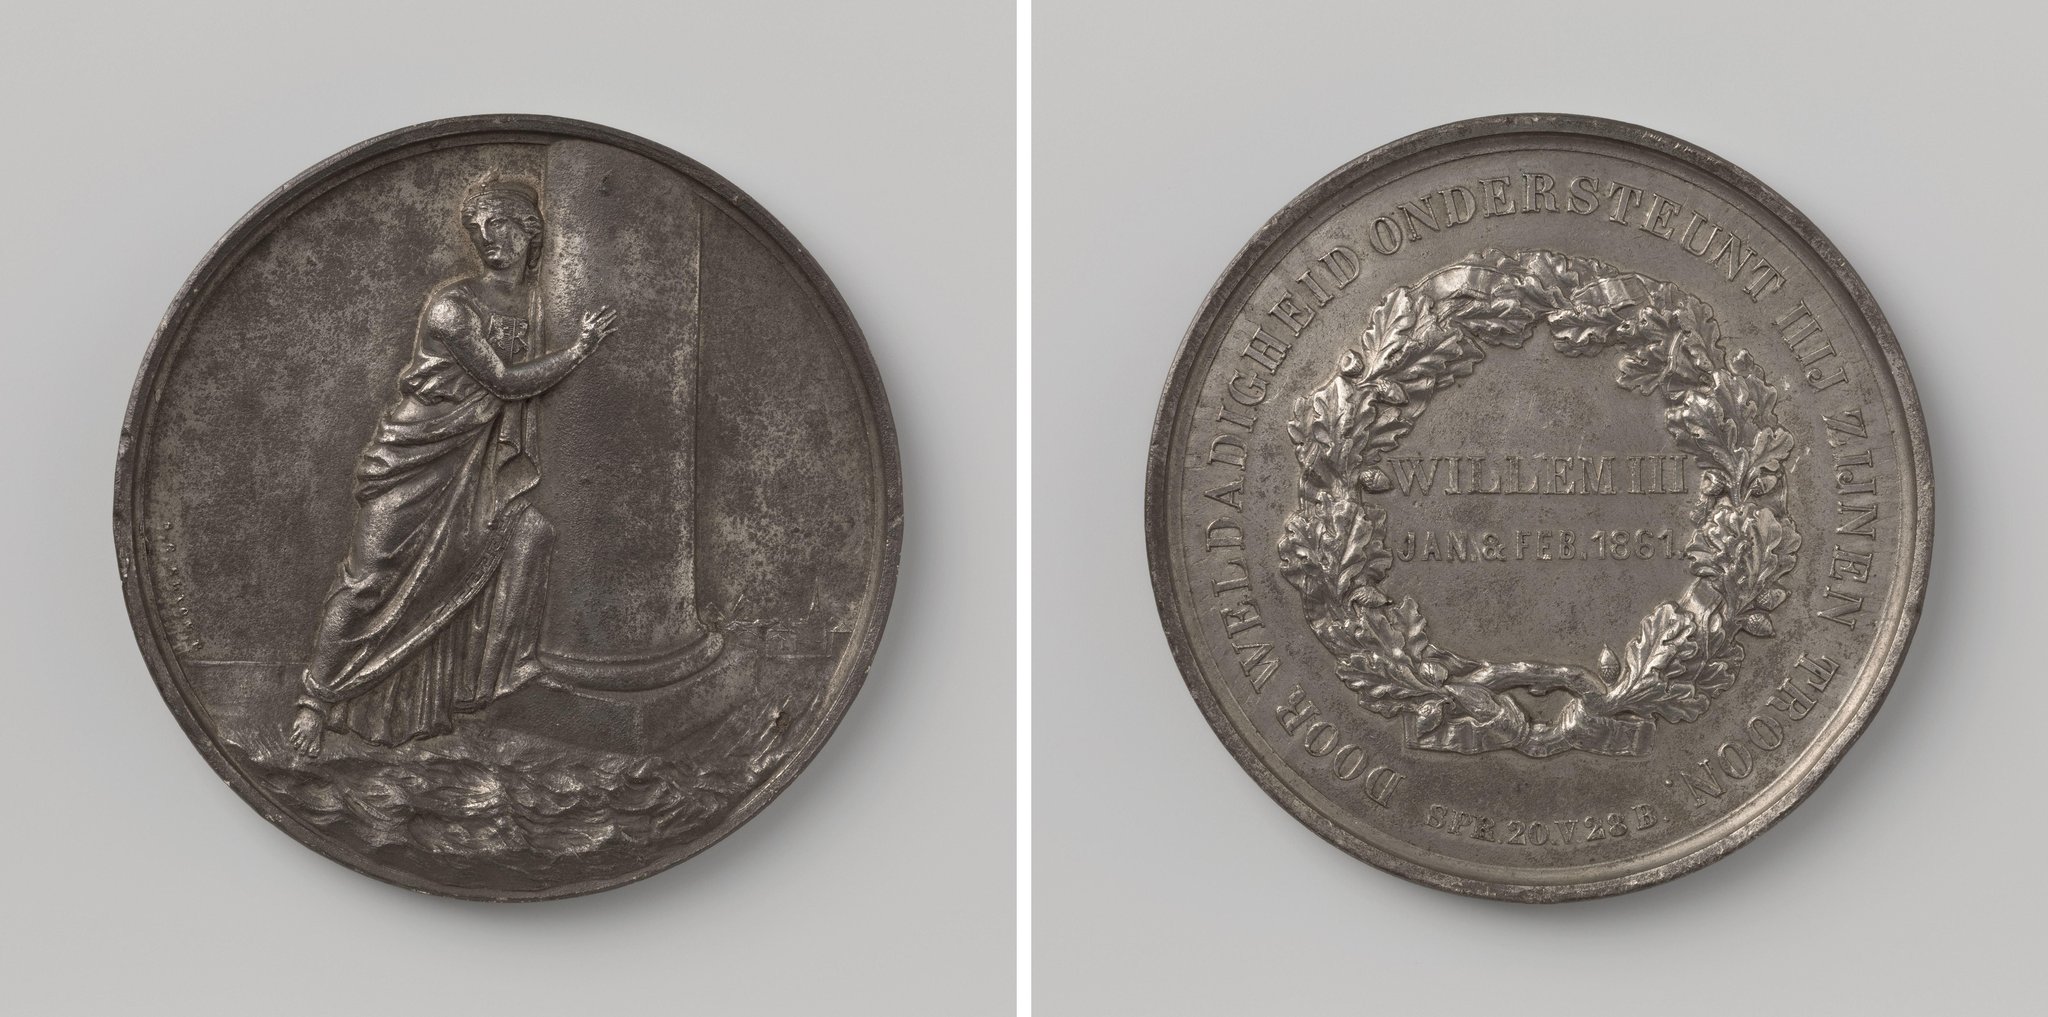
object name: honorary medal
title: Willem III, koning der Nederlanden, wegens zijn ondersteuning bij de watersnoodramp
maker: samuel cohen elion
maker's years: 1815-1880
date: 1861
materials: lead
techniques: striking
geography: amsterdam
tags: willem iii (koning der nederlanden), gelderland